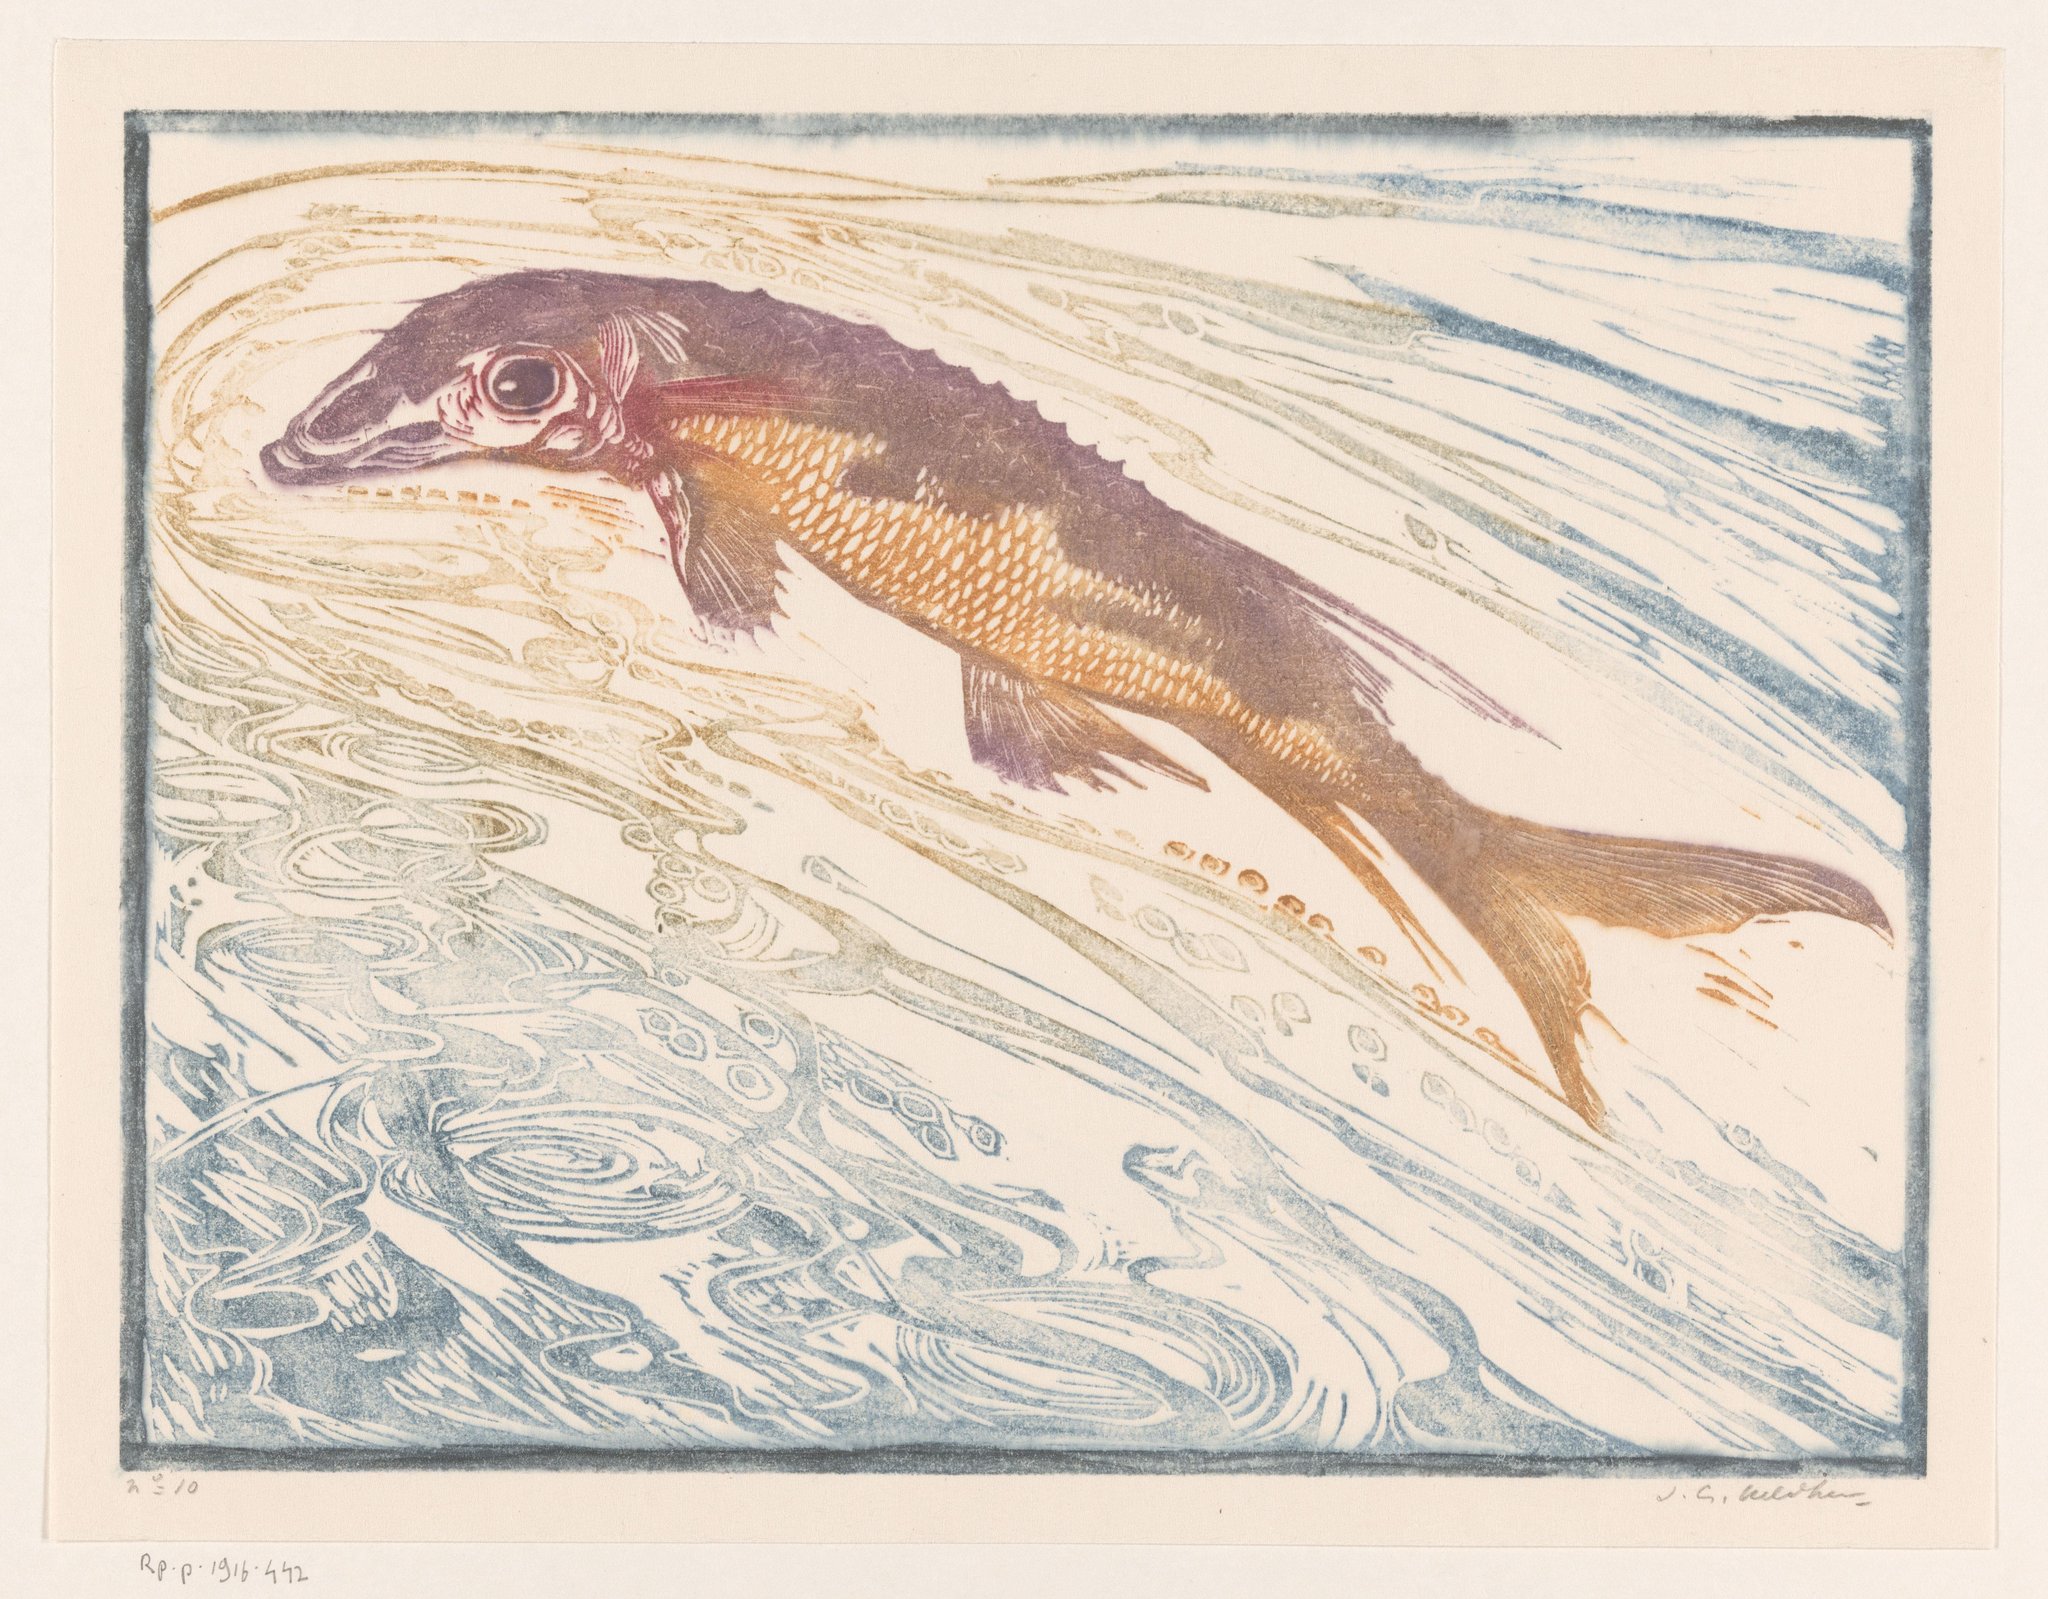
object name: print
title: Vis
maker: jacobus gerardus veldheer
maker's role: draughtsman, print maker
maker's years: 1866-1954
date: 1876-1916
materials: paper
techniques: woodcut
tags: fishes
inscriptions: collector's mark: Lugt 2233